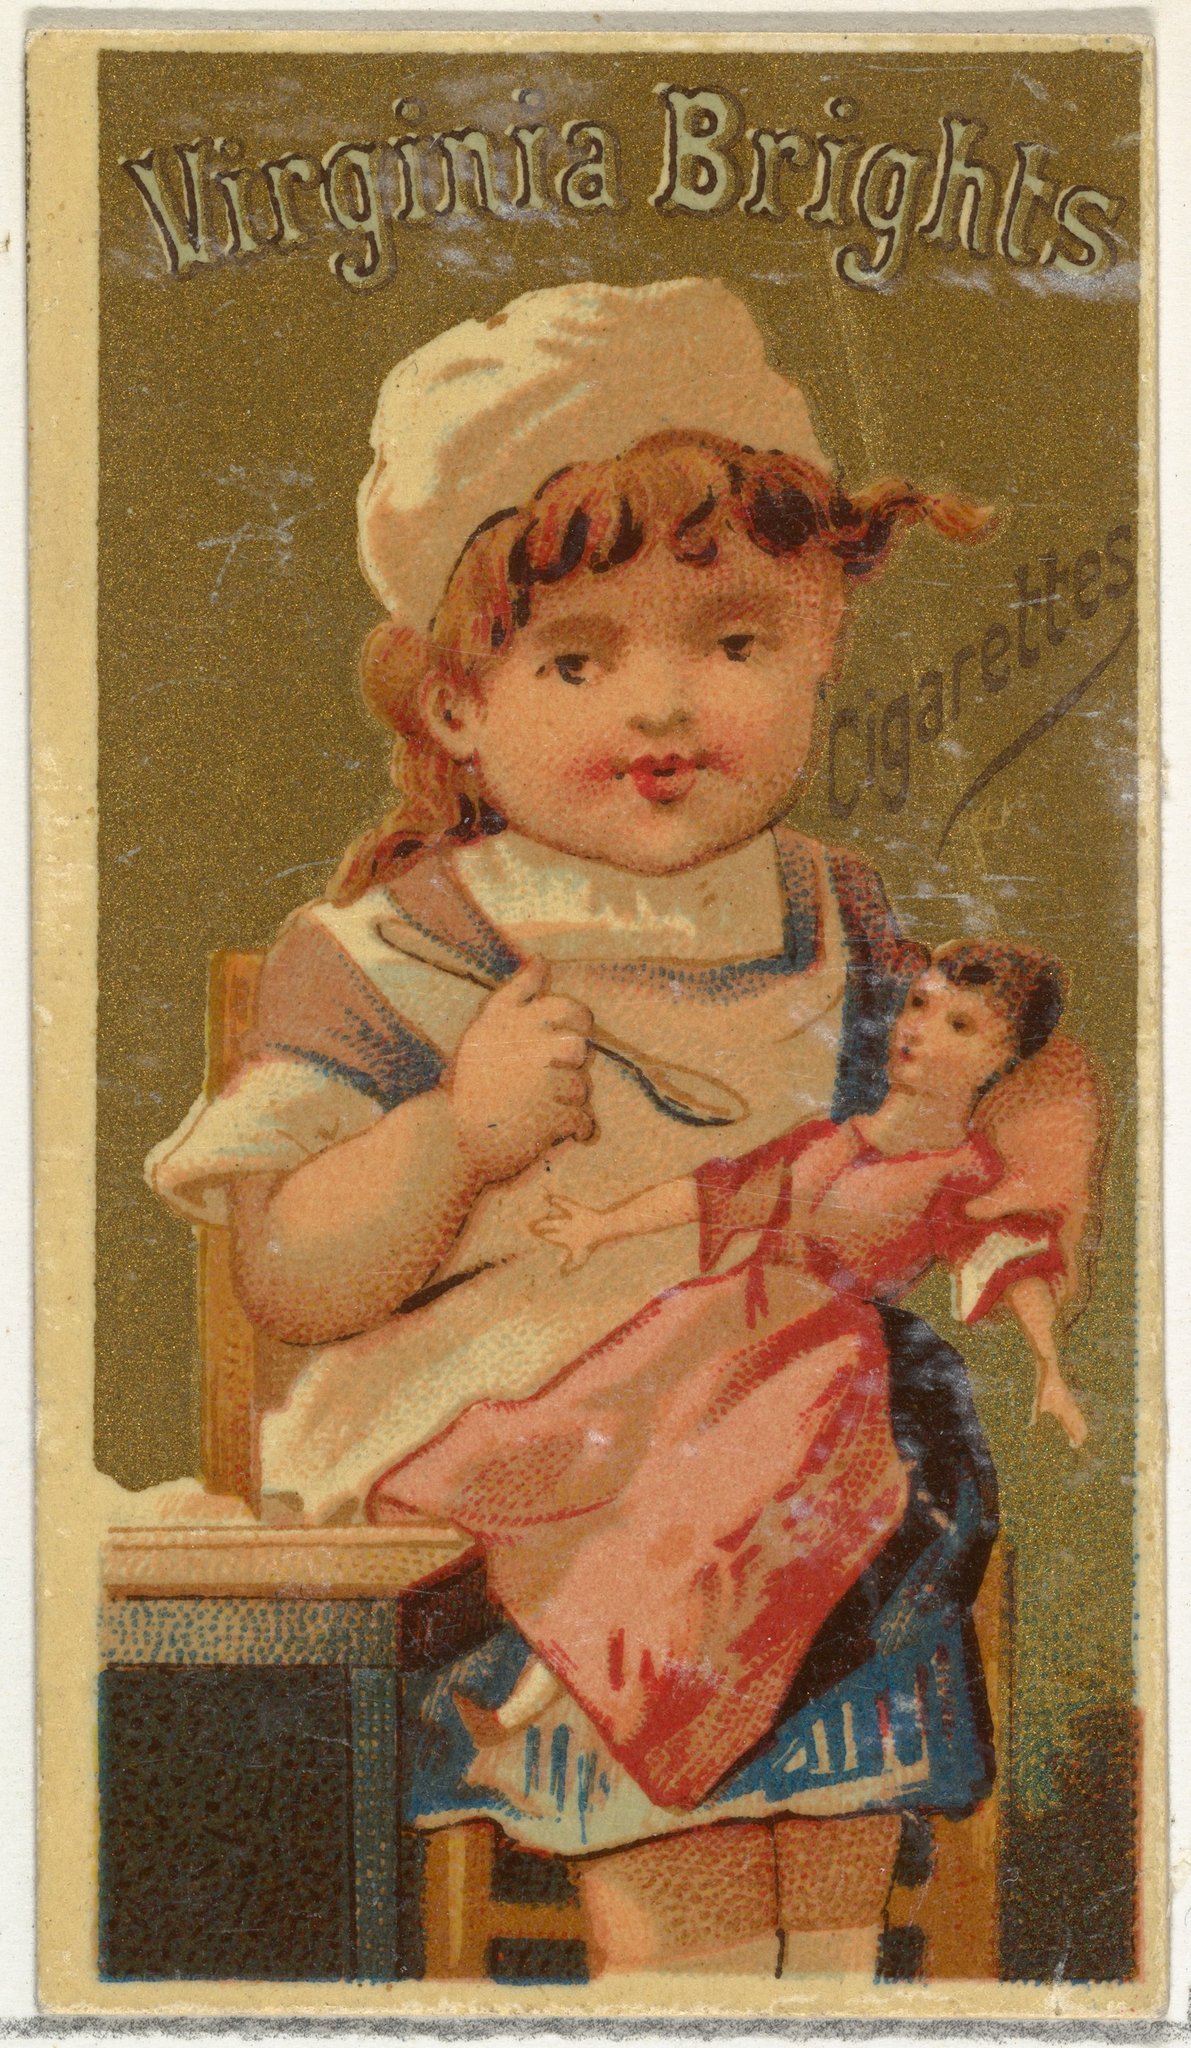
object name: print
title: From the Girls and Children series (N64) promoting Virginia Brights Cigarettes for Allen & Ginter brand tobacco products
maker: allen & ginter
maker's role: publisher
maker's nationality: american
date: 1886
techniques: color lithograph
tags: girls,dolls